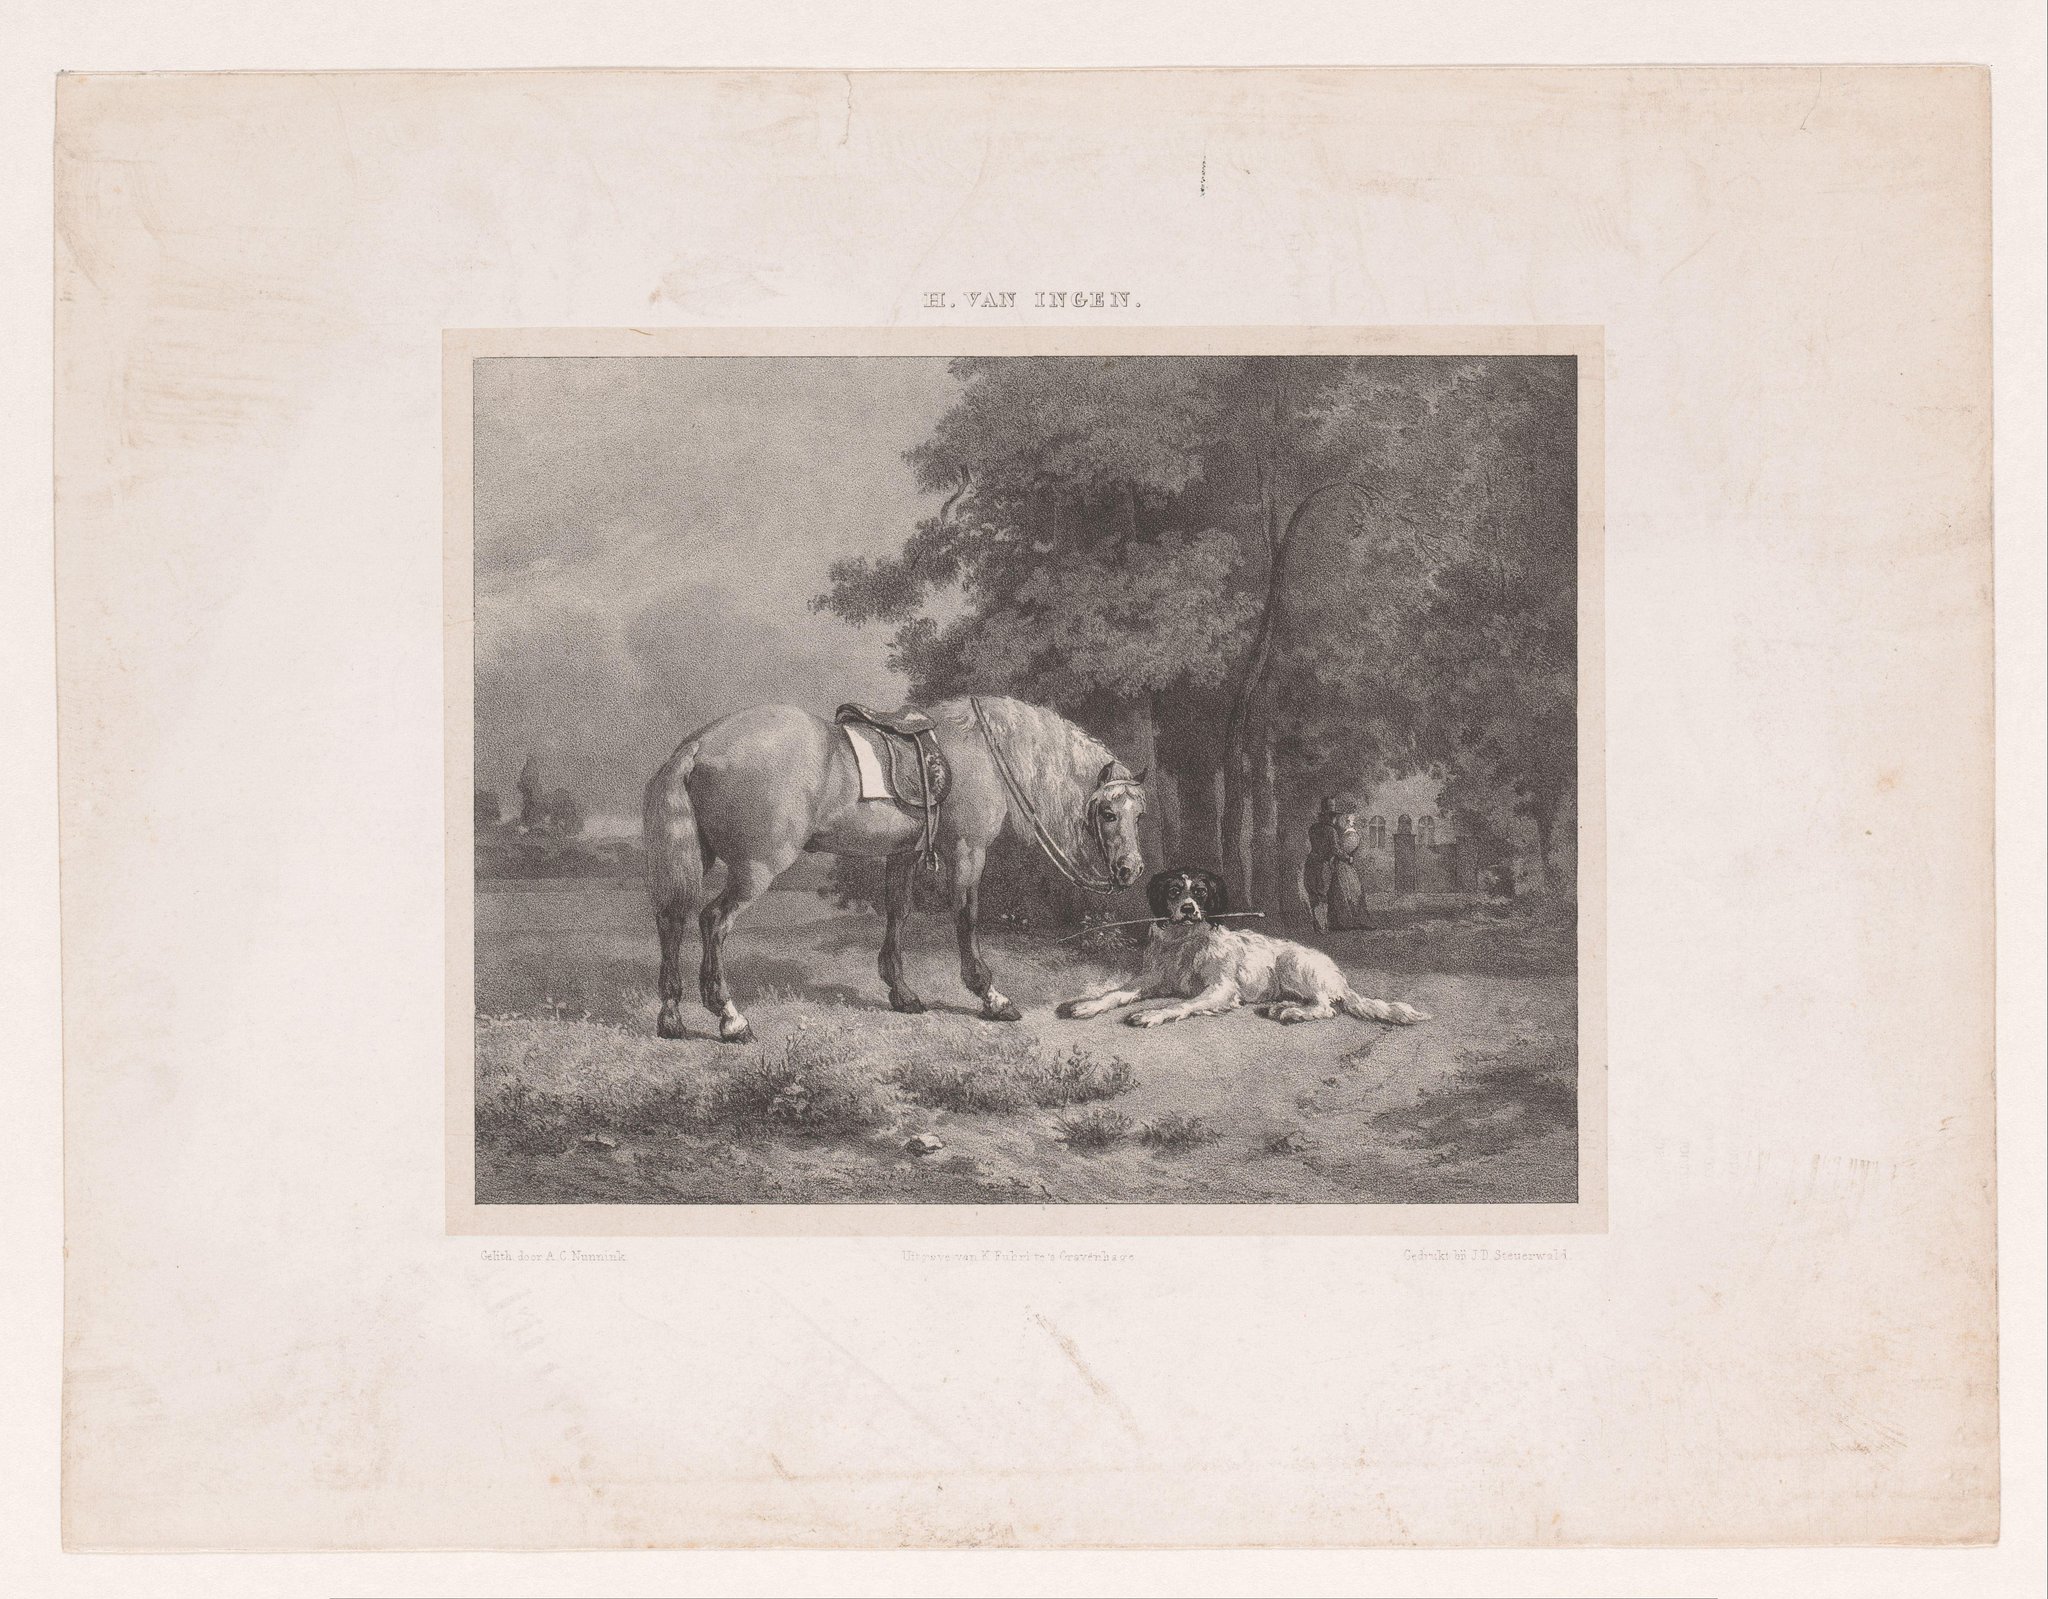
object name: print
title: Landschap met paard en hond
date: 1837-1855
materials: paper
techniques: lithograph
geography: the hague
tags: horse, dog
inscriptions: collector's mark: Lugt 2228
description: Een paard staat bij een liggende hond met een tak in zijn bek. Rechts in de achtergrond staan een man en vrouw op een pad voor een huis.